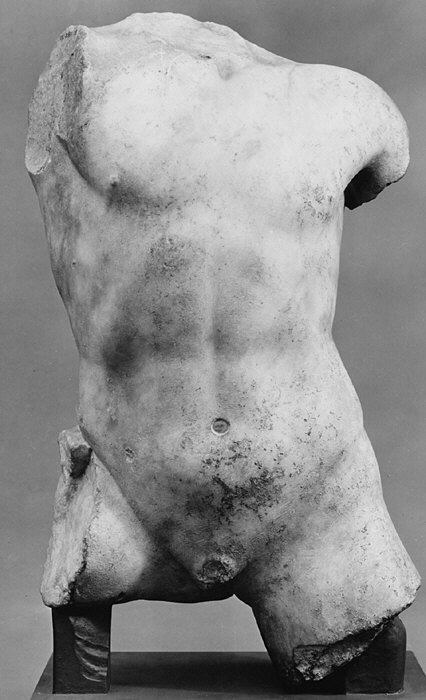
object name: torso of a boy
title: Marble torso of a boy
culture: roman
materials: marble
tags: boys